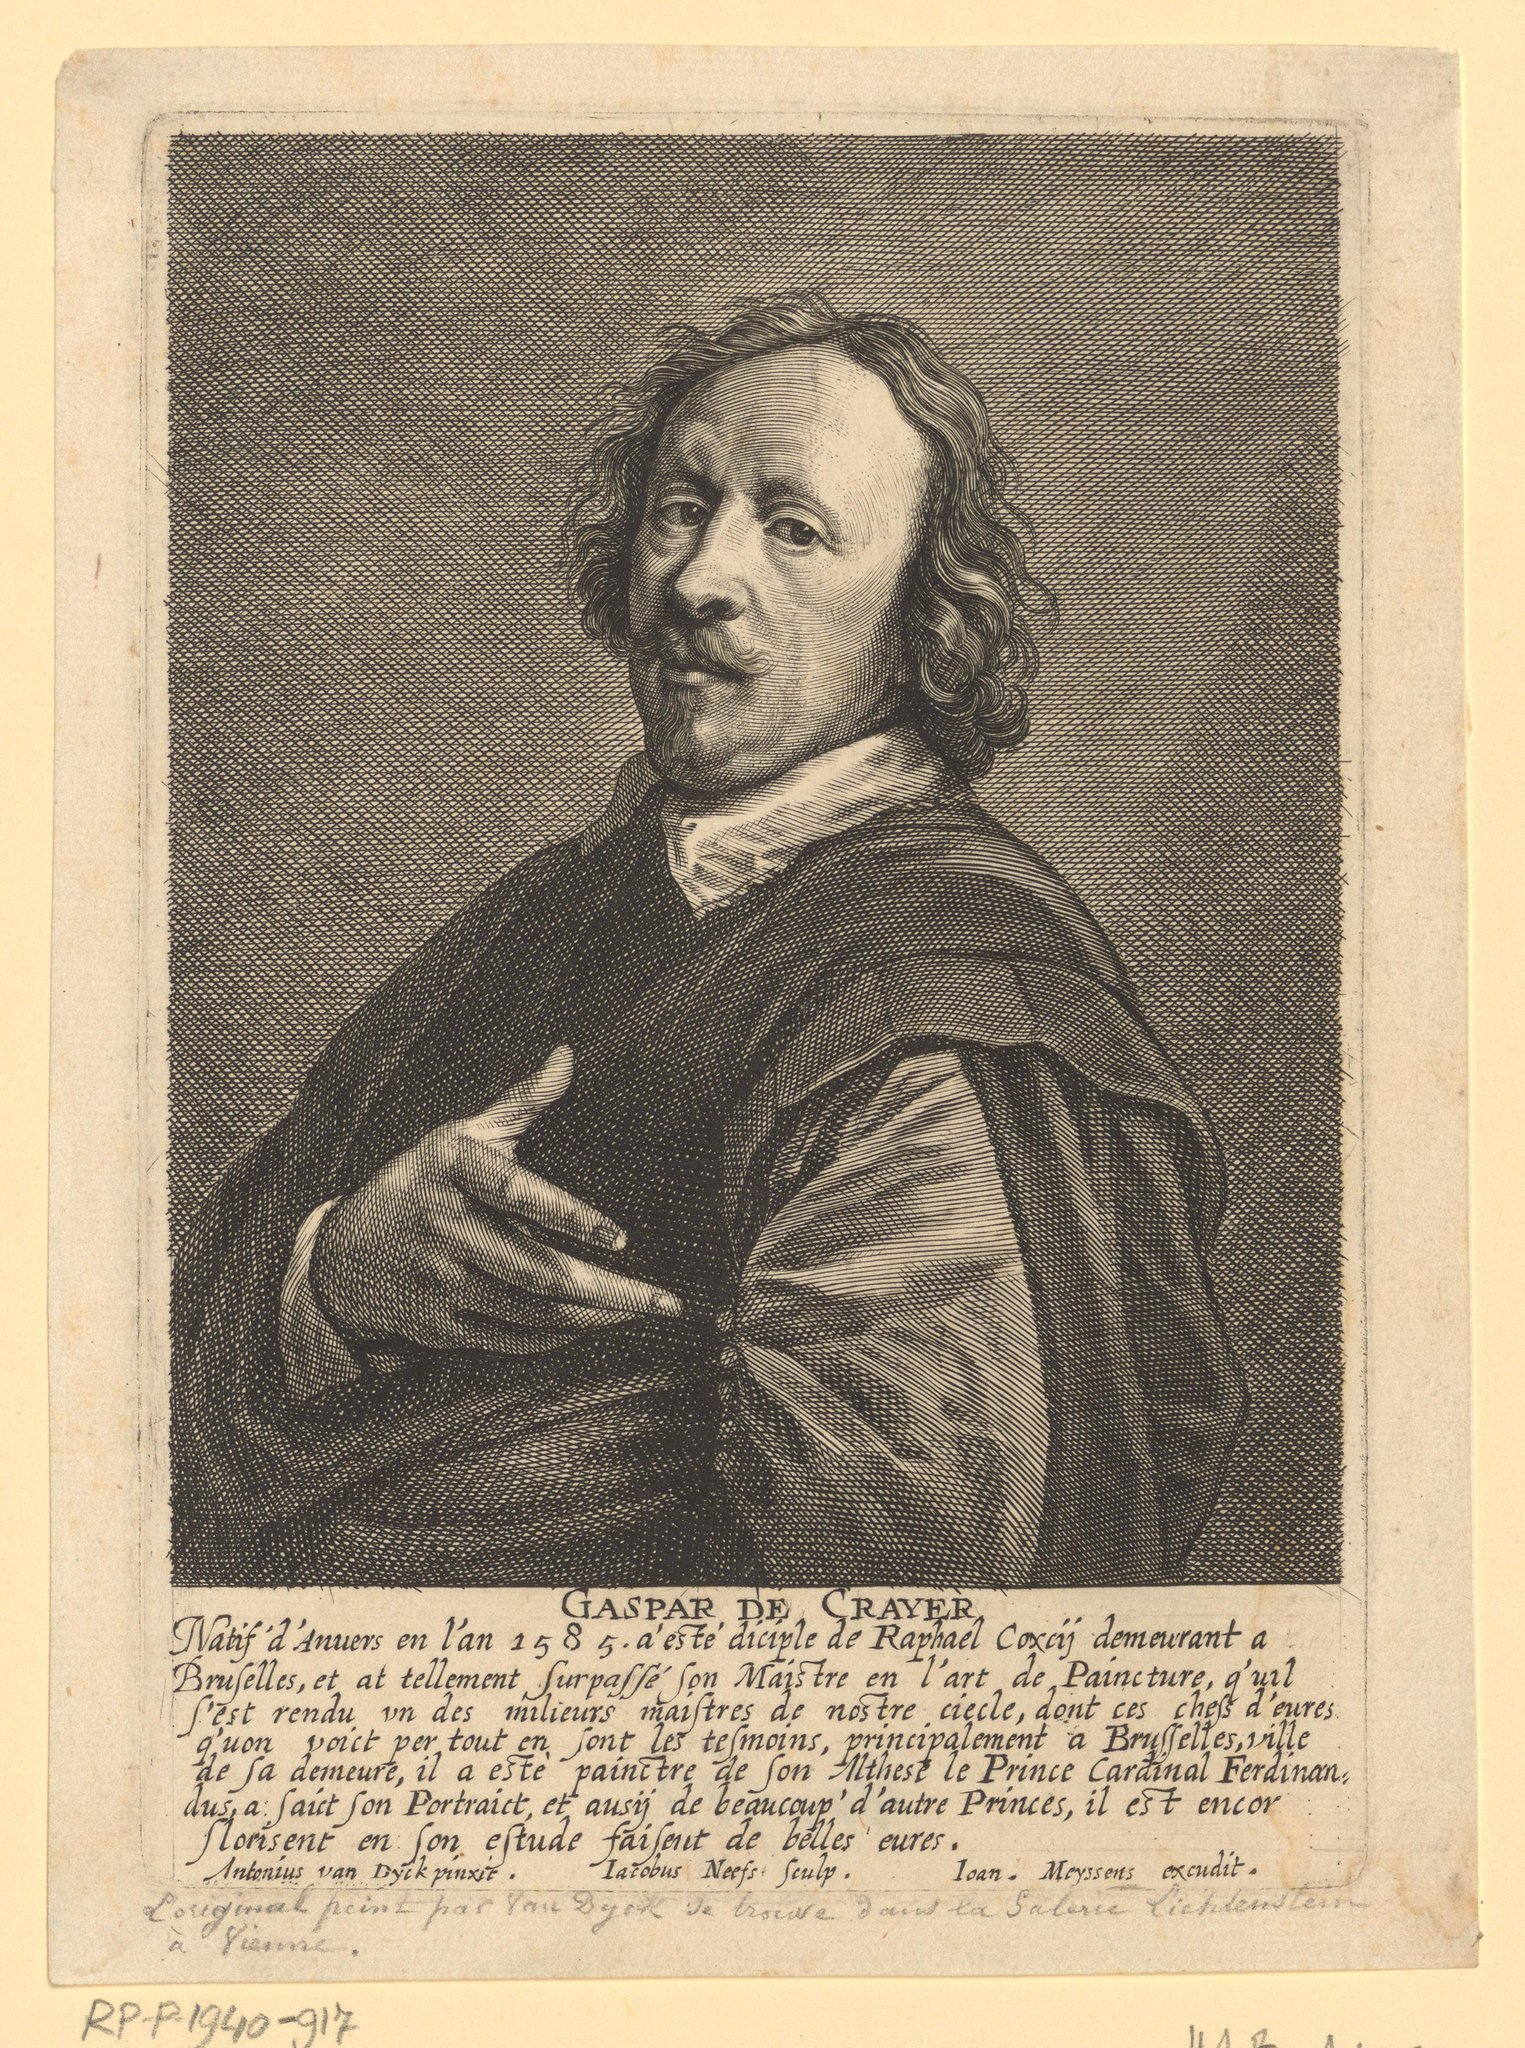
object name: print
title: Portretten van diverse mannen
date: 1649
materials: paper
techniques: engraving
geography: antwerp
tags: antwerp, ghent, print maker, draughtsman, gaspar de crayer, historical persons, portrait, self-portrait of painter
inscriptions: collector's mark: Lugt 2228, collector's mark: Lugt 732, collector's mark: Lugt 2760